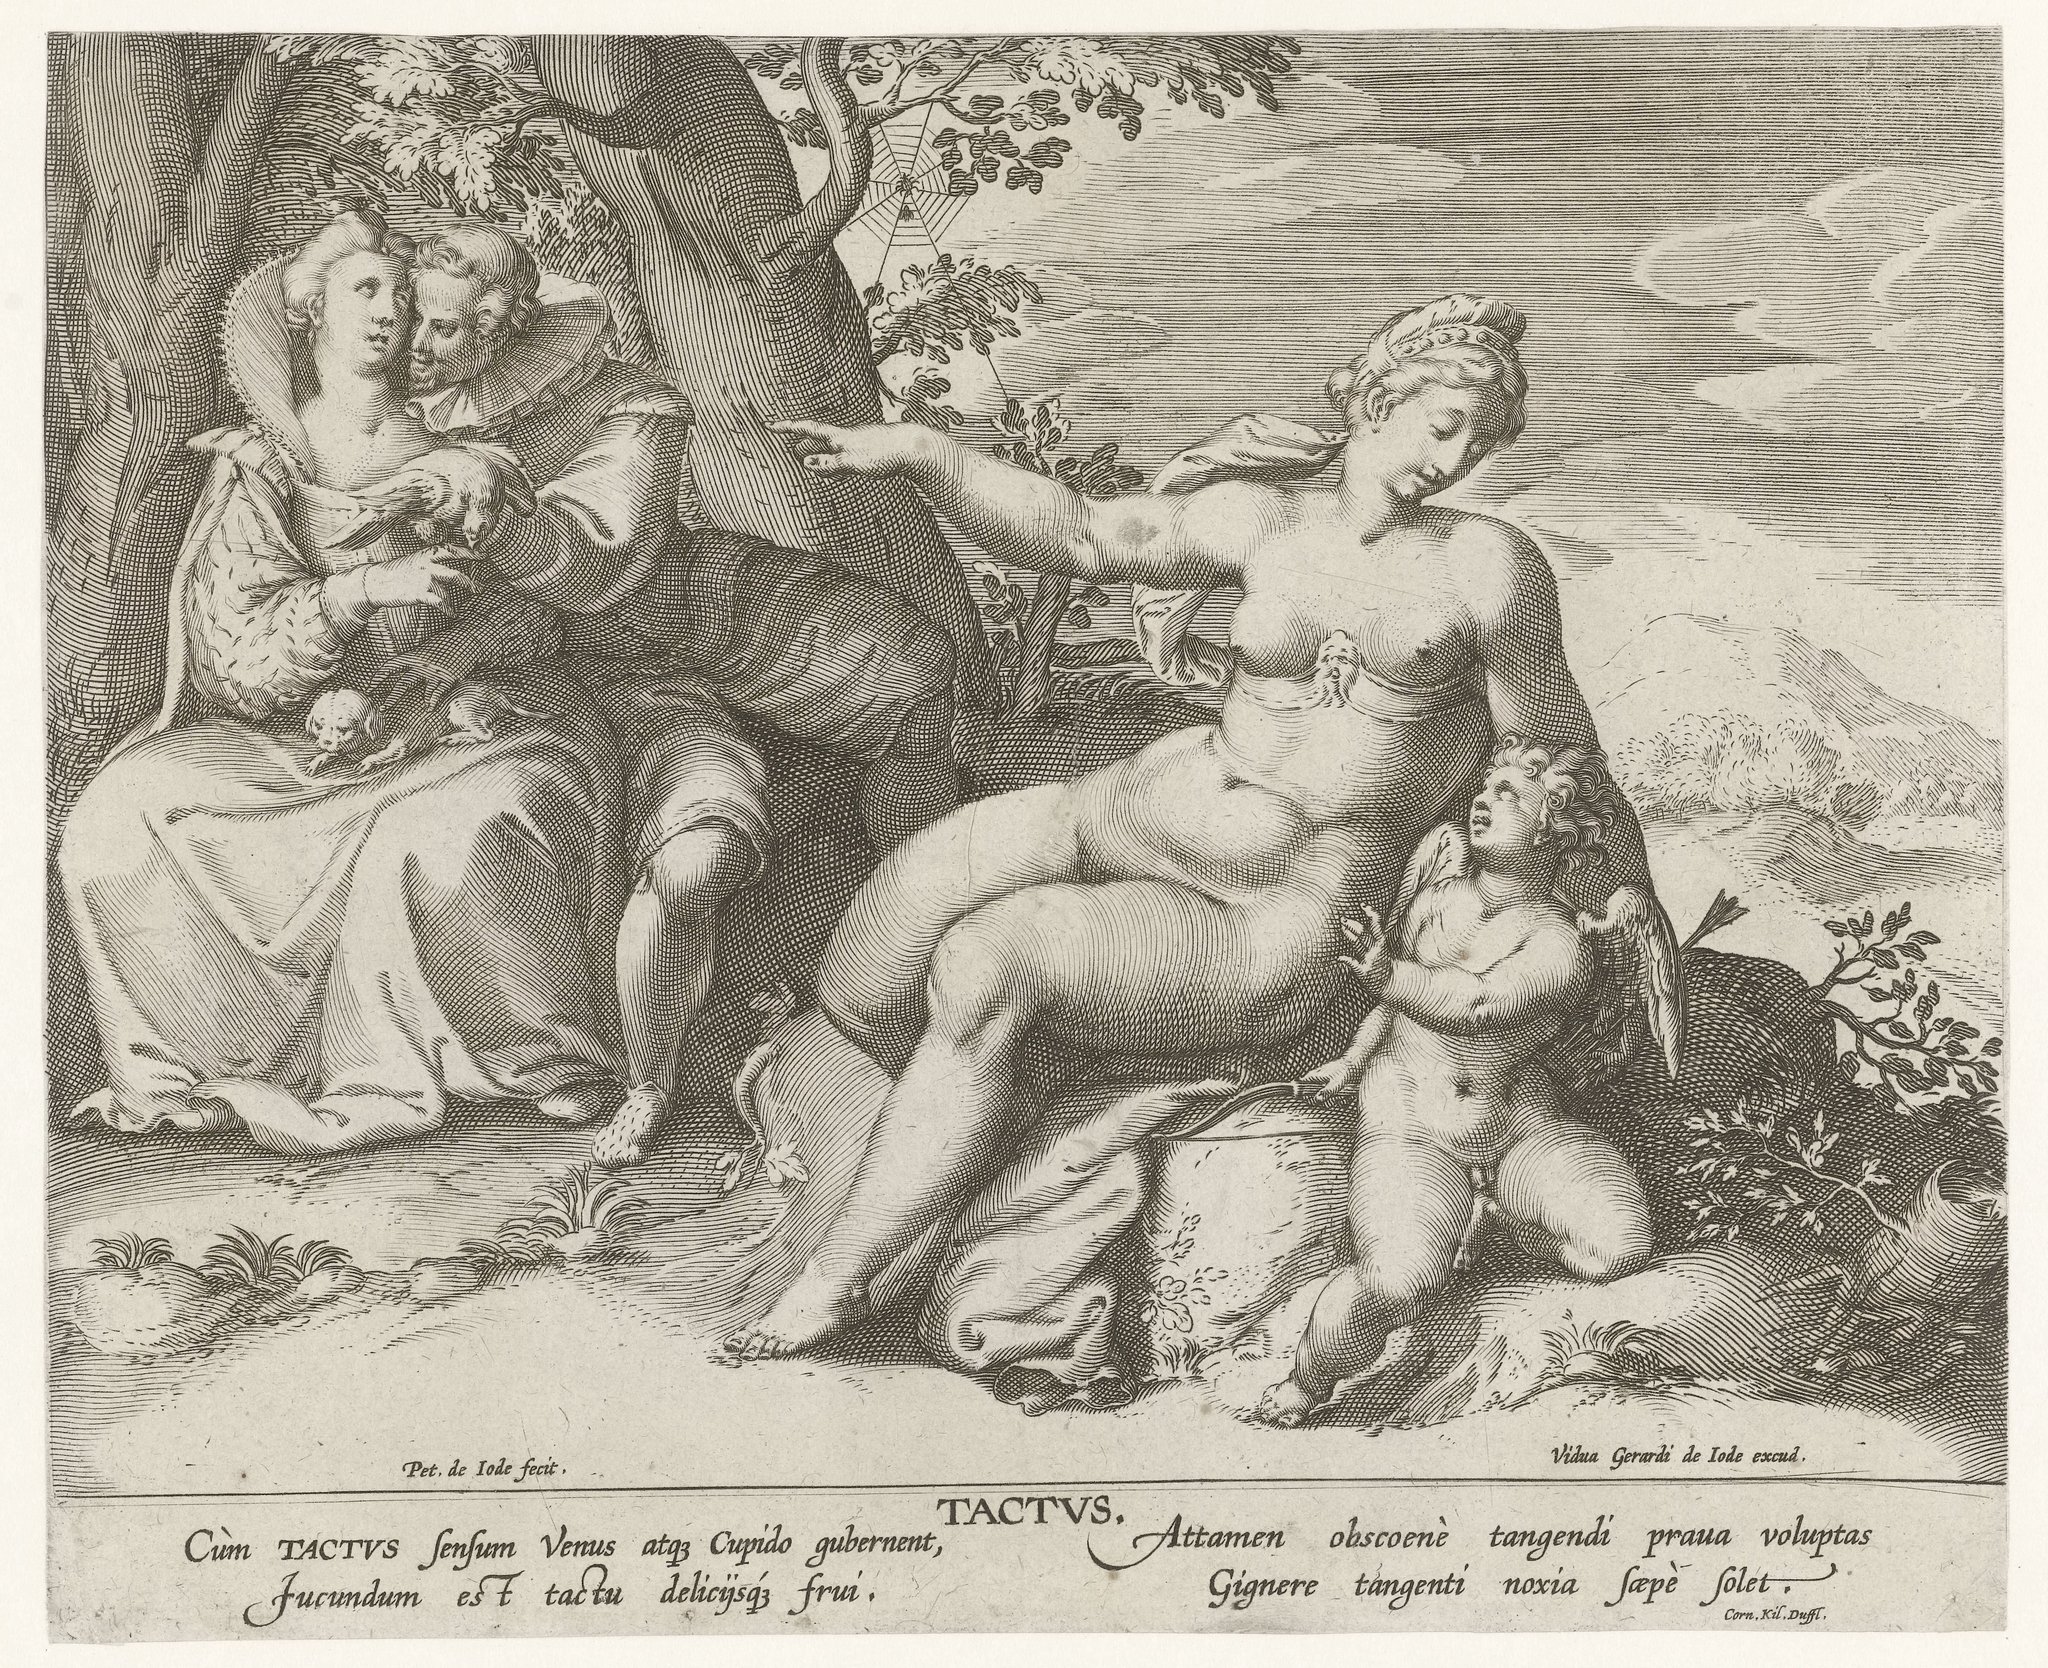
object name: print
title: Tastzin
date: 1590-1632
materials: paper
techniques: engraving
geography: antwerp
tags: feeling (one of the five senses)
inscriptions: collector's mark: Lugt 2228, collector's mark: Lugt 2760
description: Landschap met de vrouwelijke personificatie van de Tastzin, met een duif op haar hand. Een man omhelst haar en aait de hond die op haar schoot zit. Op de voorgrond Venus en Amor. In de marge, in twee kolommen, een onderschrift in het Latijn. Prent uit een serie van vijf met de vijf zintuigen.